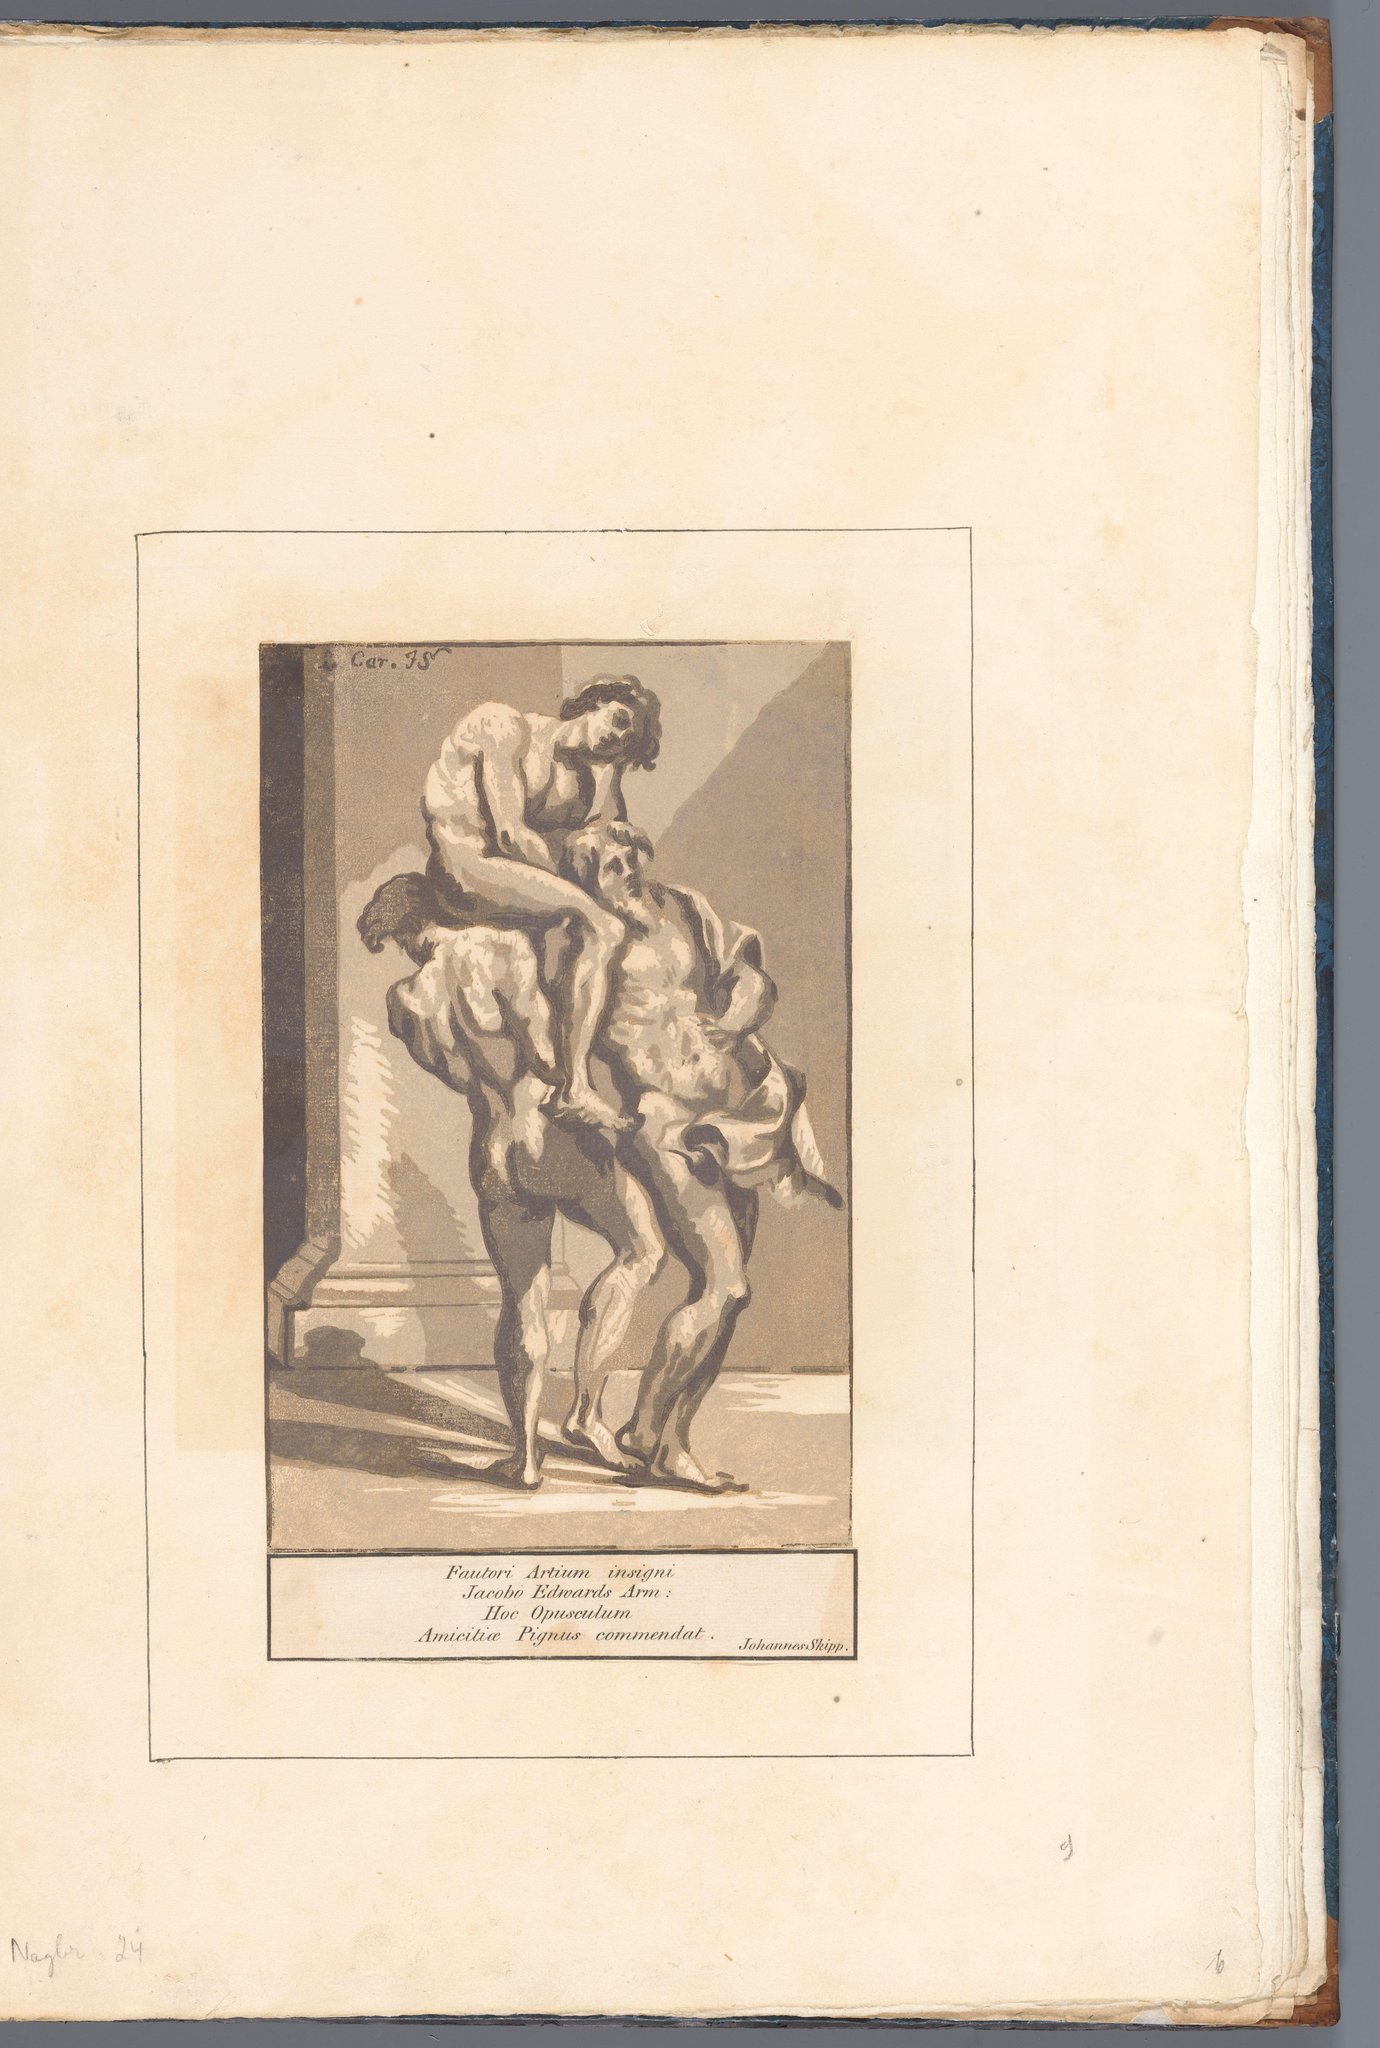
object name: print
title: Amicis suis necnon unicuique (...)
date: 1781-1809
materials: ink, paper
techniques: woodcut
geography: england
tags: carrying a person on one's back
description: Twee naakte mannen dragen op hun schouders een derde man. Met etiket met vierregelige tekst in het Latijn waarin de naam: Jacob Edwards. Onderdeel van een album met 26 ingeplakte clair-obscur houtsneden naar Italiaanse kunstenaars uit de zestiende eeuw.